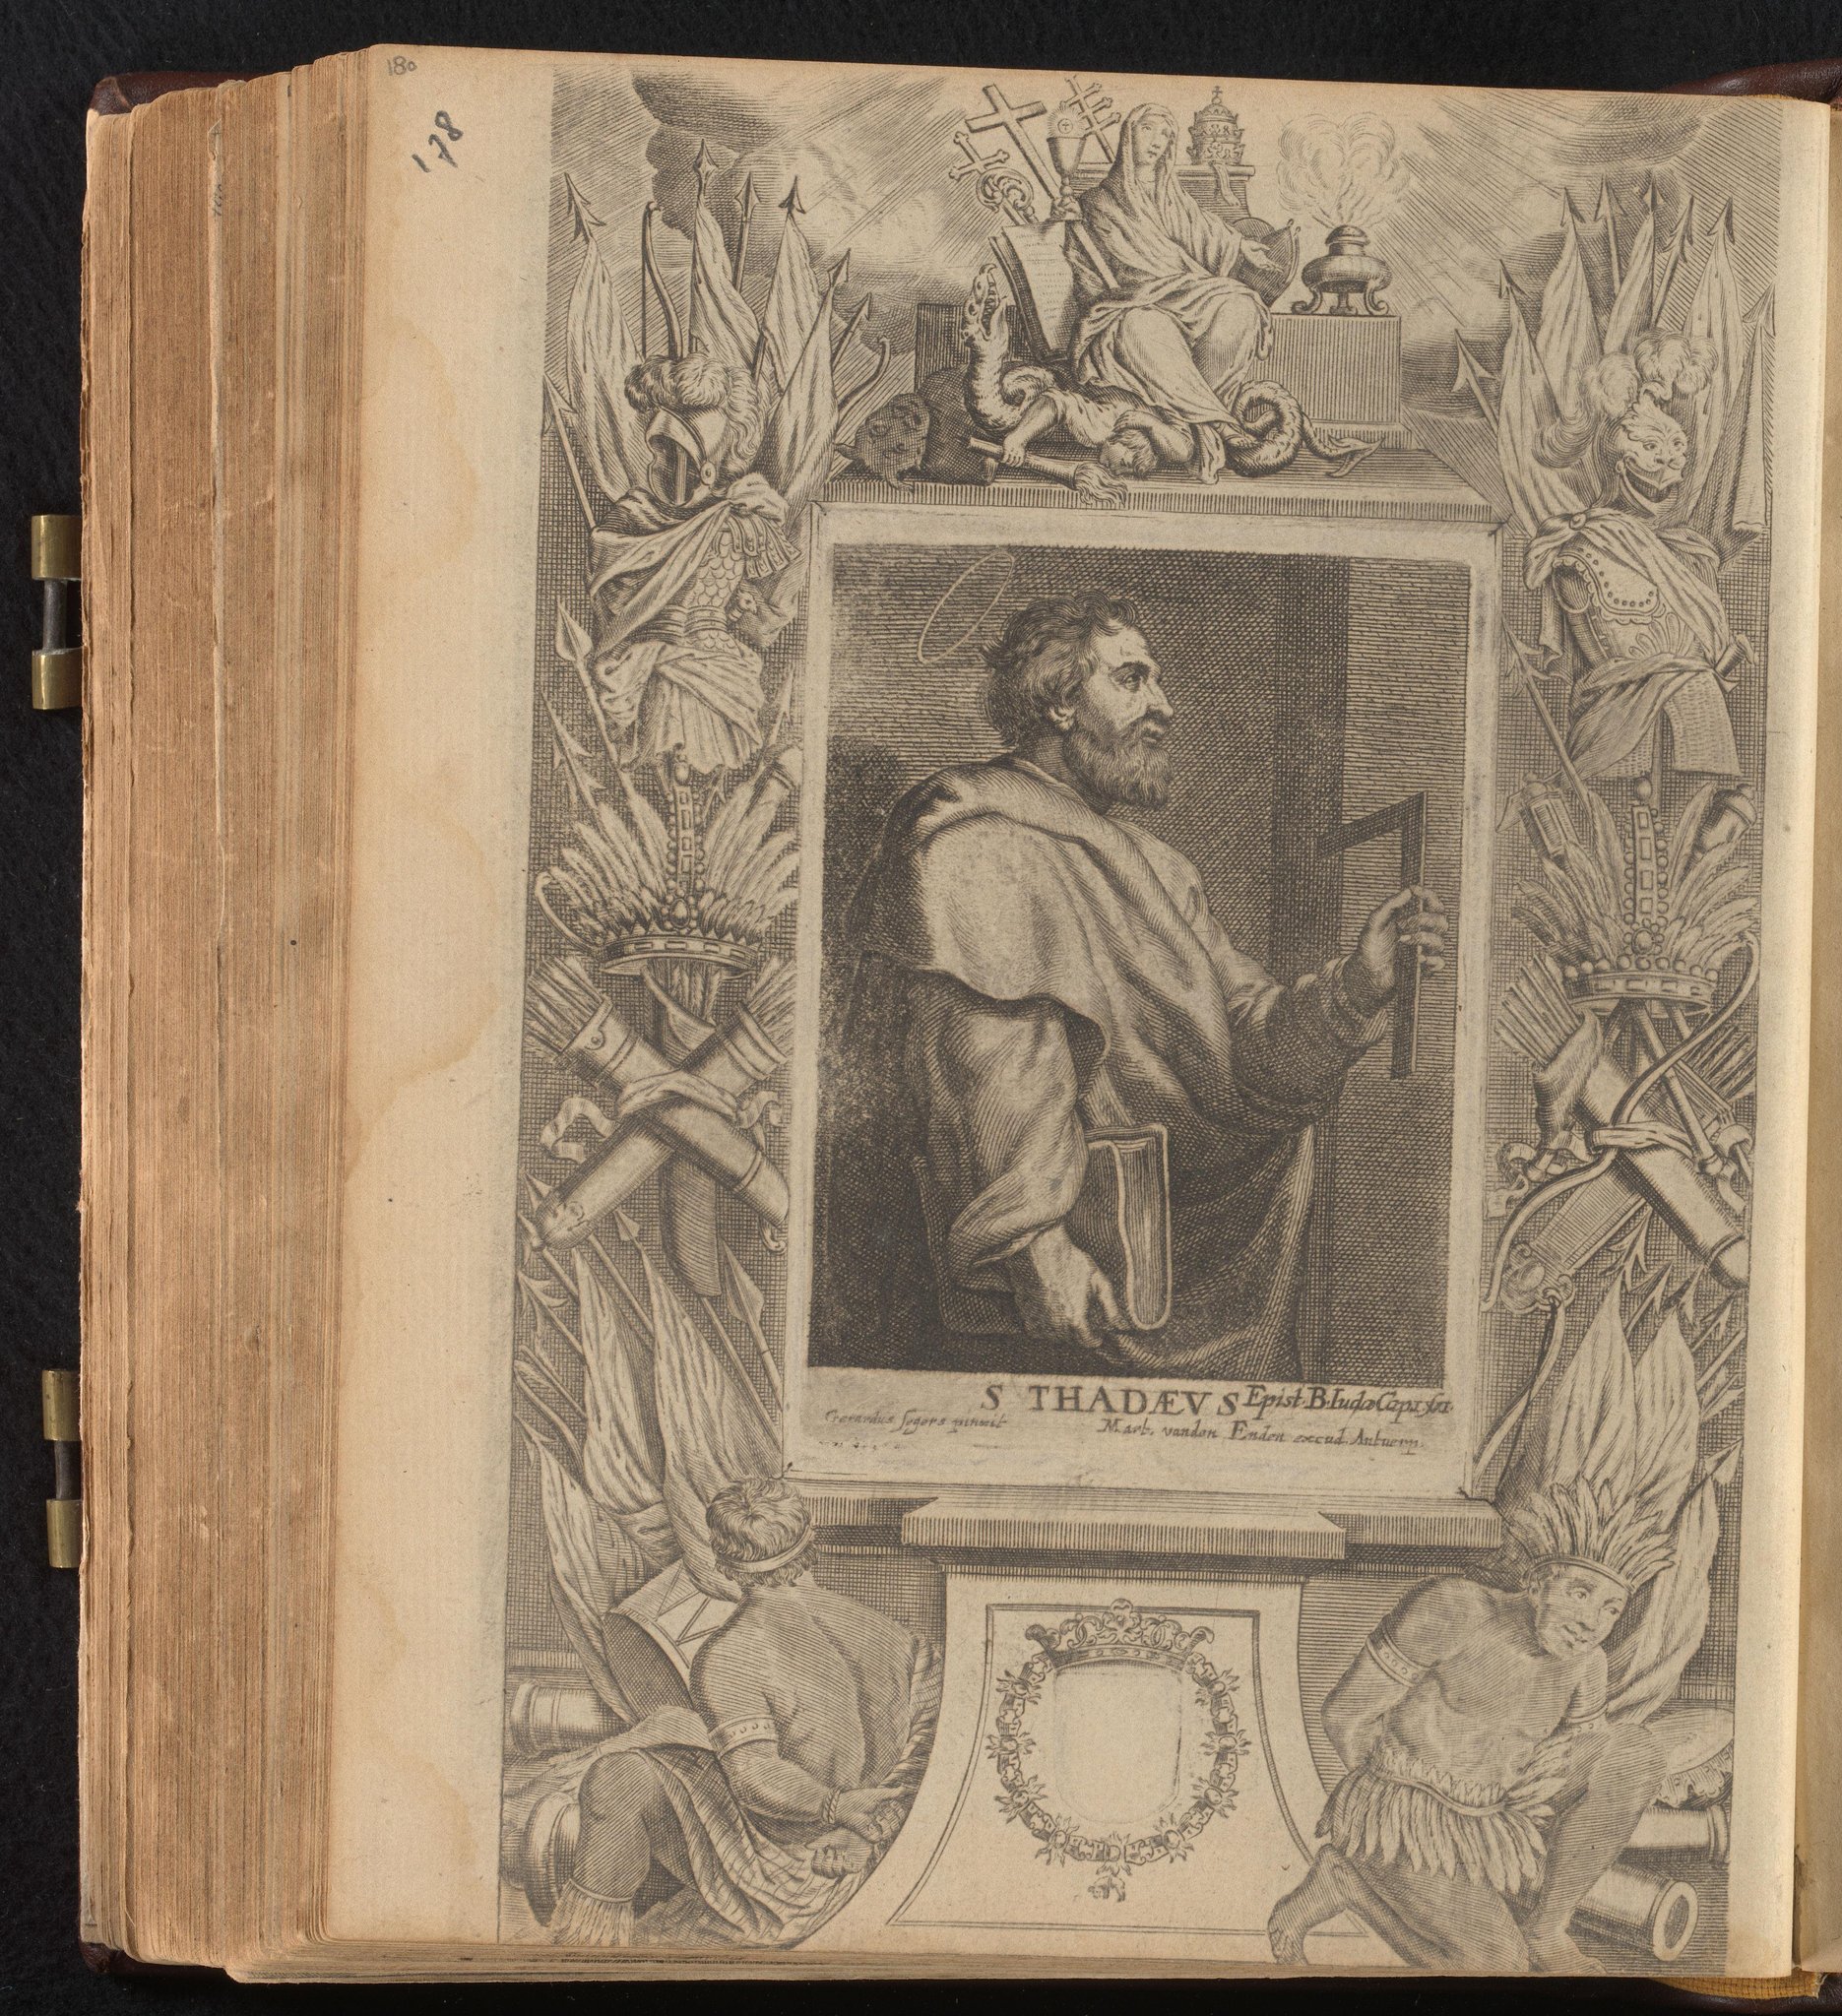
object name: album leaf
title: Heilige Judas Taddeüs met winkelhaak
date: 1783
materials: paper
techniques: engraving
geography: antwerp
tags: fides (faith) as roman personification, archer's weapons: bow and arrow, the apostle jude thaddaeus; possible attributes: book, club, halberd, scroll, armour, indigenous peoples of north america, armorial bearing, heraldry, smoking pot as symbol of 'vanitas'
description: Prent maakt deel uit van een prentbijbel.